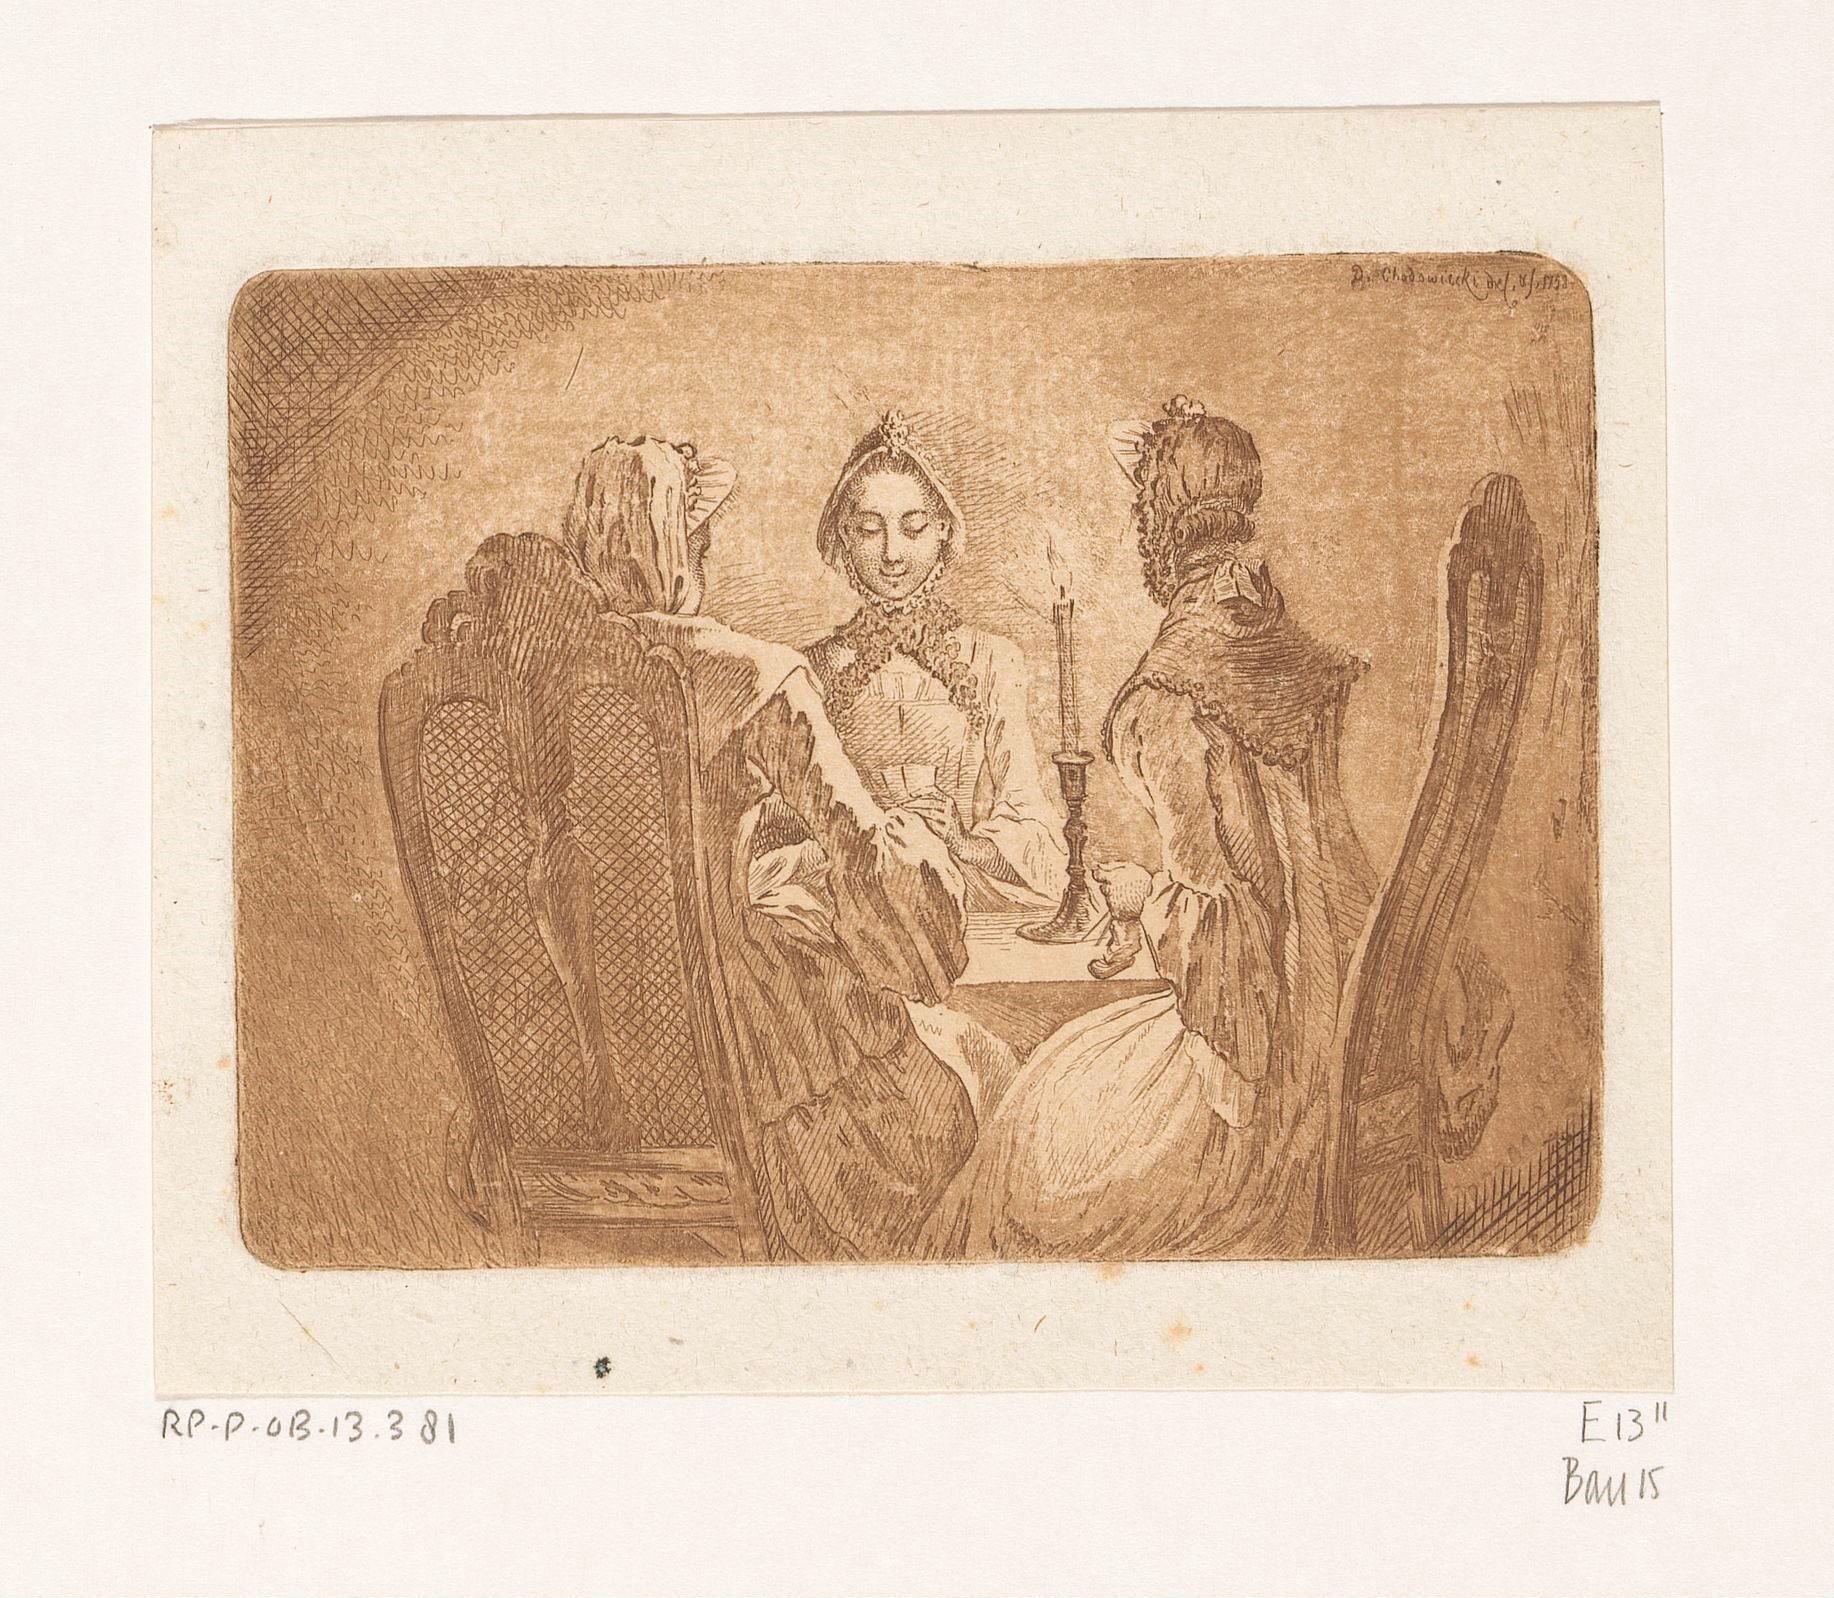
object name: print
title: Drie kaartspelende dames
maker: daniel nikolaus chodowiecki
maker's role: draughtsman, print maker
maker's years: 1726-1801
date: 1758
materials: paper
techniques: aquatint, etching, intaglio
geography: berlin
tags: historical persons - bb - woman, card games, candlestick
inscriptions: collector's mark: Lugt 2228